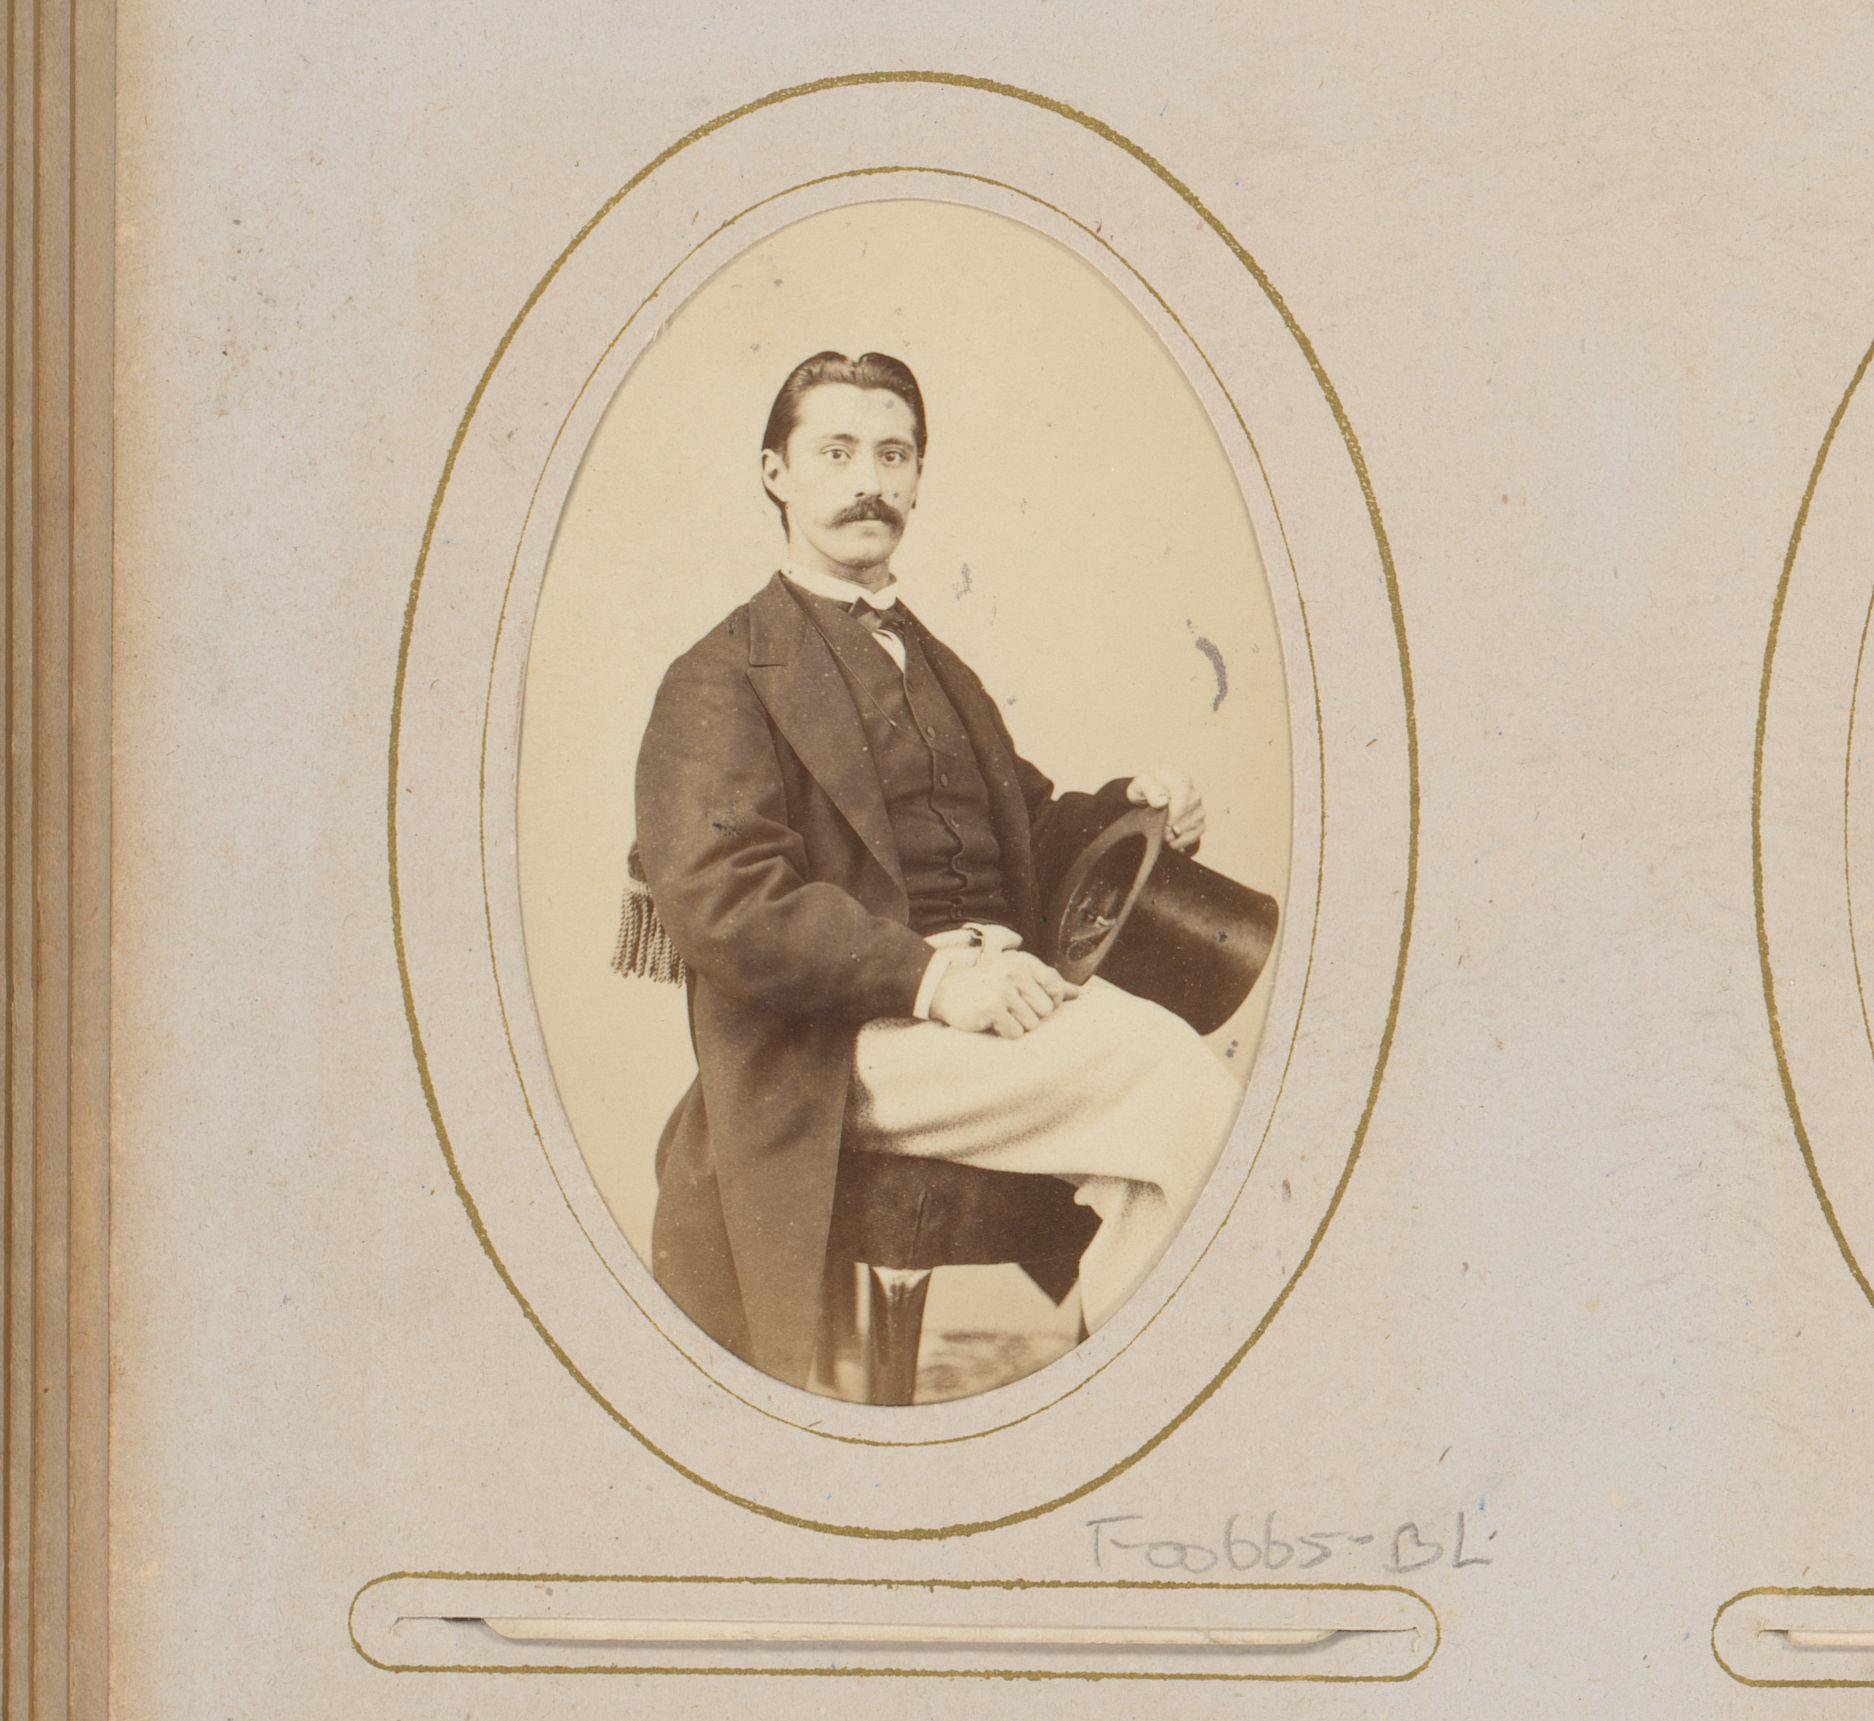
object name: album leaf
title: Portret van een man met hoge hoed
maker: jacobus van gorkom (jr.)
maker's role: print maker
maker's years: 1827-1880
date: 1862-1871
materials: cardboard, photographic support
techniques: albumen print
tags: historical persons, head-gear: top hat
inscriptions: inscription: ‘J. van Gorkom Jr./ Photographie/ Rotterdam/ Kruiskade/ Wijk.14, 592’